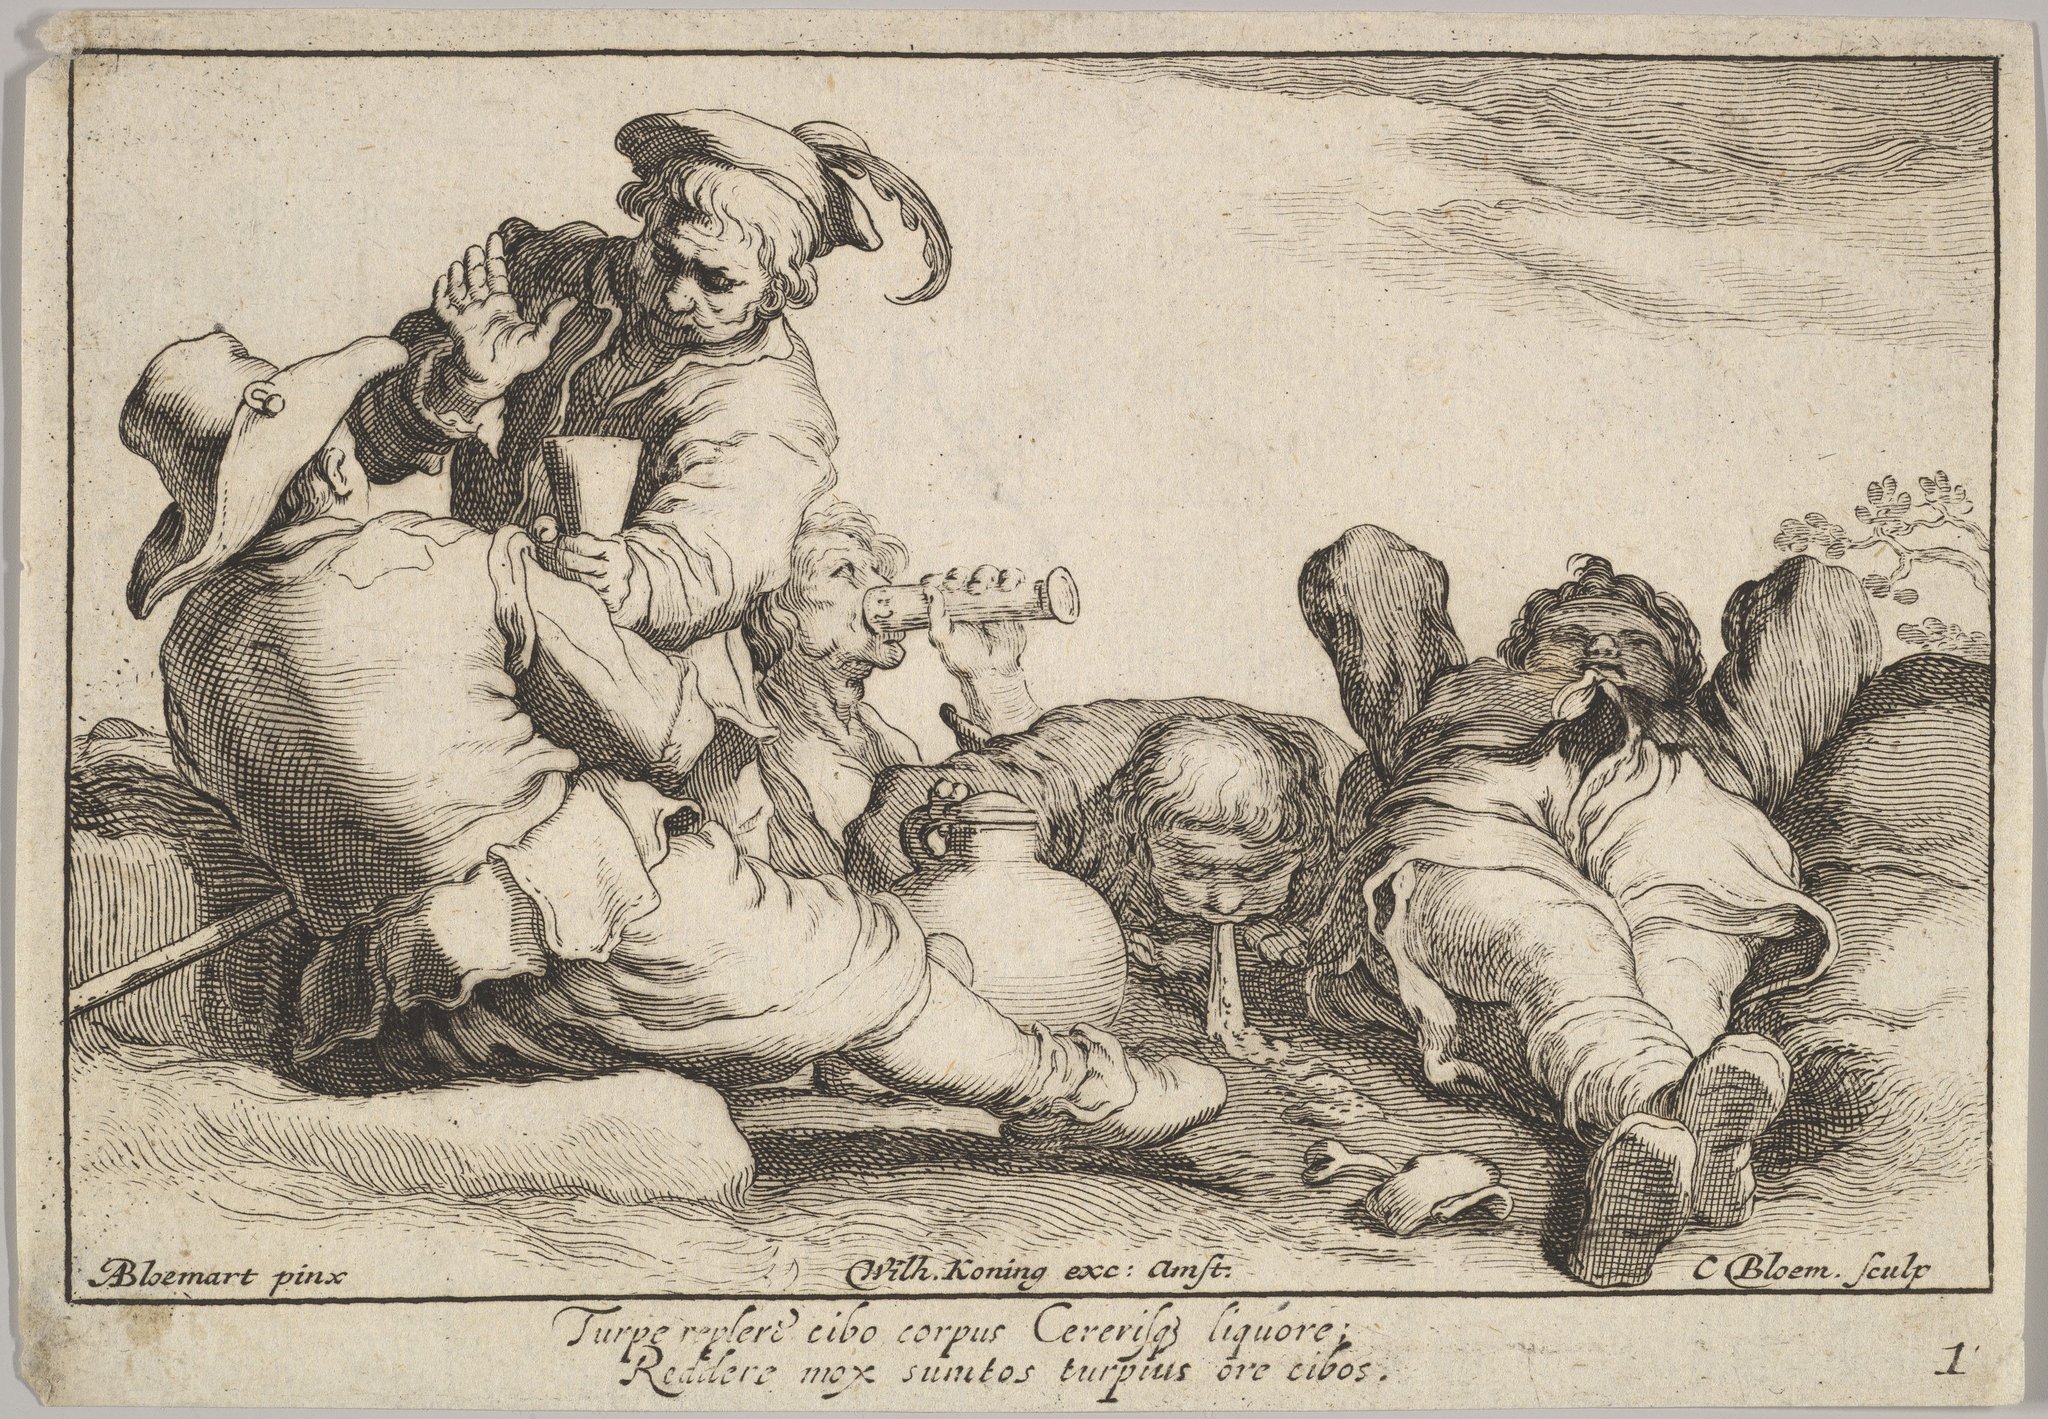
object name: print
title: Pleasures of Occupation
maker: cornelis bloemaert (ii)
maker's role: artist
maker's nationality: dutch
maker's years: 1603-1684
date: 1620-1684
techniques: engraving, etching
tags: sleeping,men,drinking